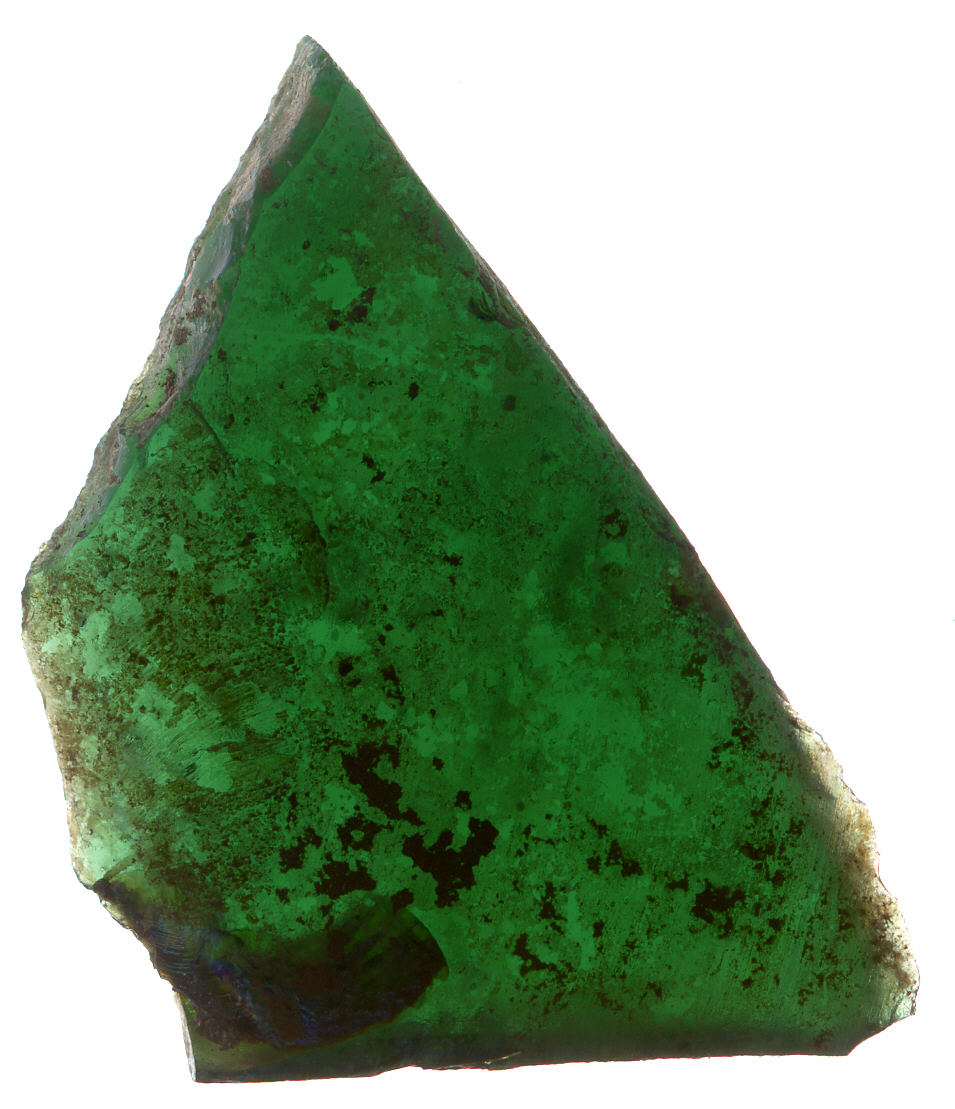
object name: fragment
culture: crusader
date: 1201-1300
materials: glass